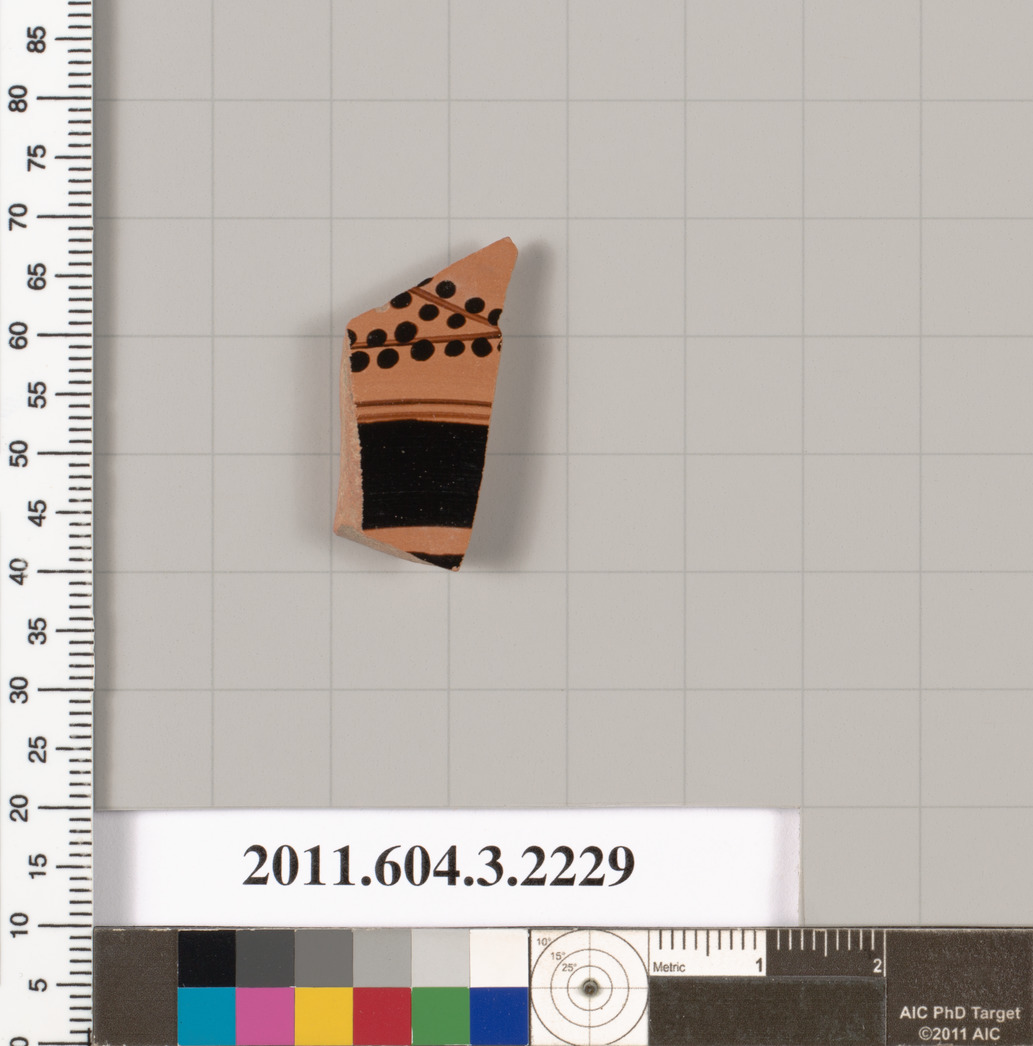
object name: kylix fragment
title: Terracotta fragment of a kylix (drinking cup)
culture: greek, attic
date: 525-501 BCE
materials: terracotta